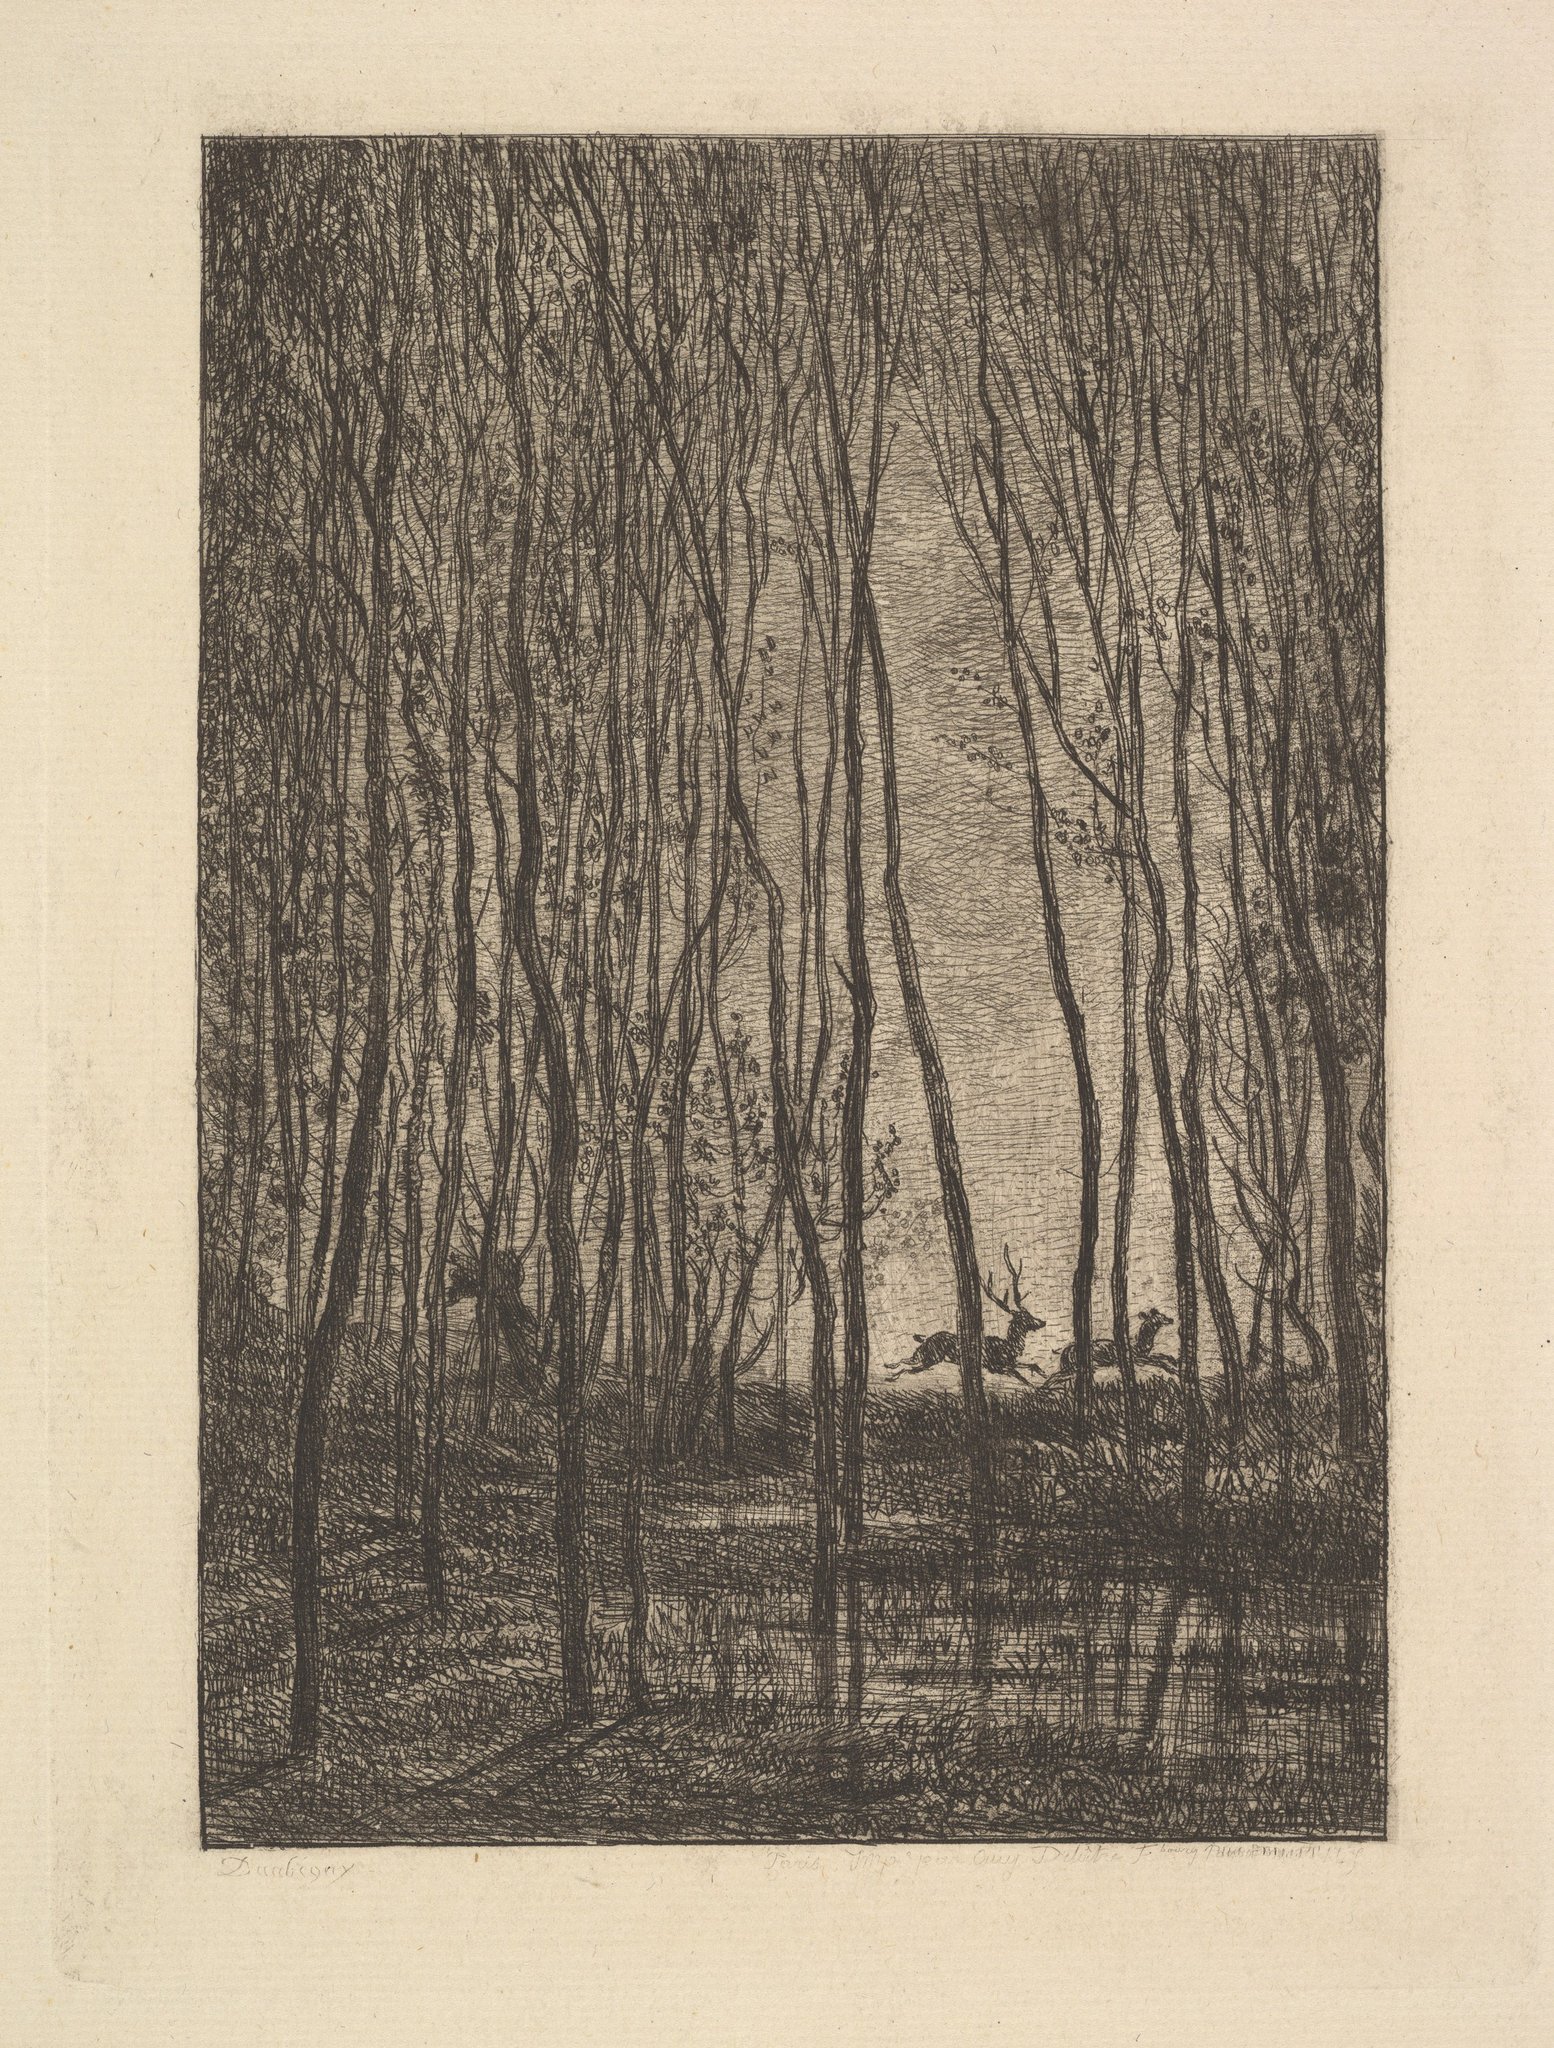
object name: print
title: Deer in the Woods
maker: charles-françois daubigny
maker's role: artist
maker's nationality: french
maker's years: 1817-1878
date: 1850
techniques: etching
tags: deer,forests